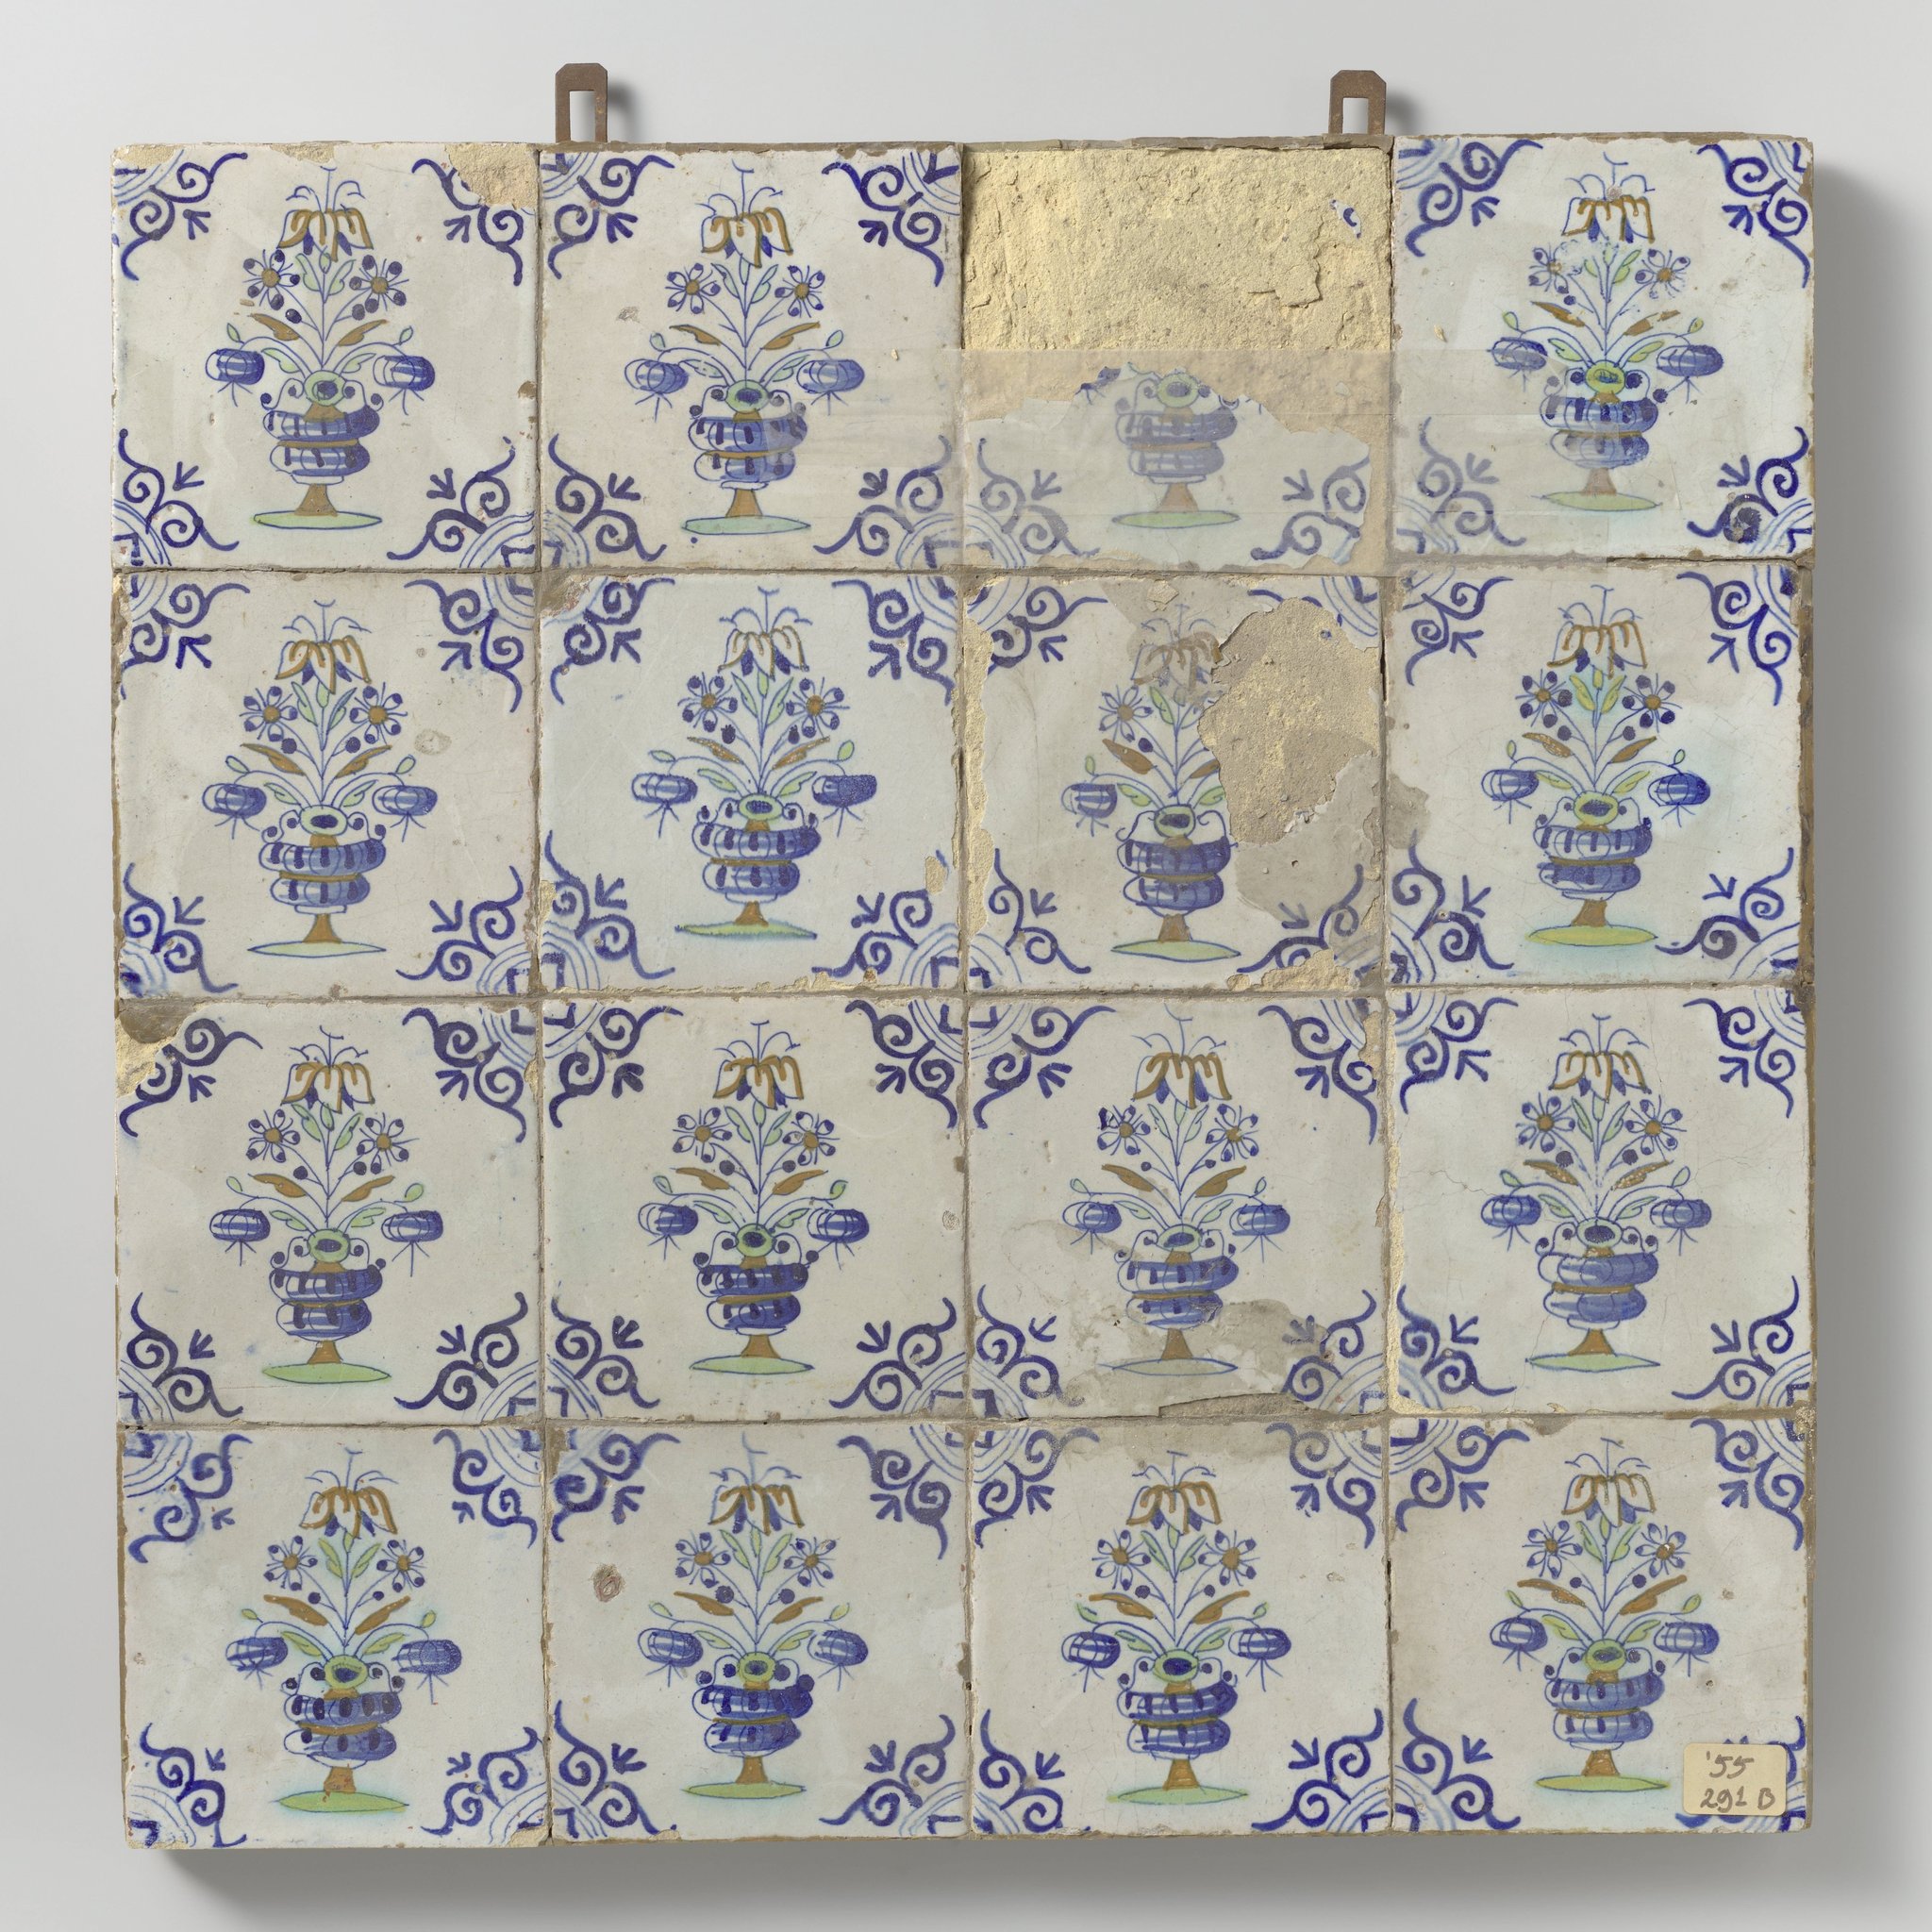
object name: tegelveld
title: Veld van zestien tegels met bloempotten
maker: Anonymous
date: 1625-1670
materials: earthenware, glaze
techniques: maiolica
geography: netherlands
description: Veld van zestien tegels (4 x 4) met een veelkleurige (blauw, groen en oranje) bloempot met in de hoeken, een ossenkop.